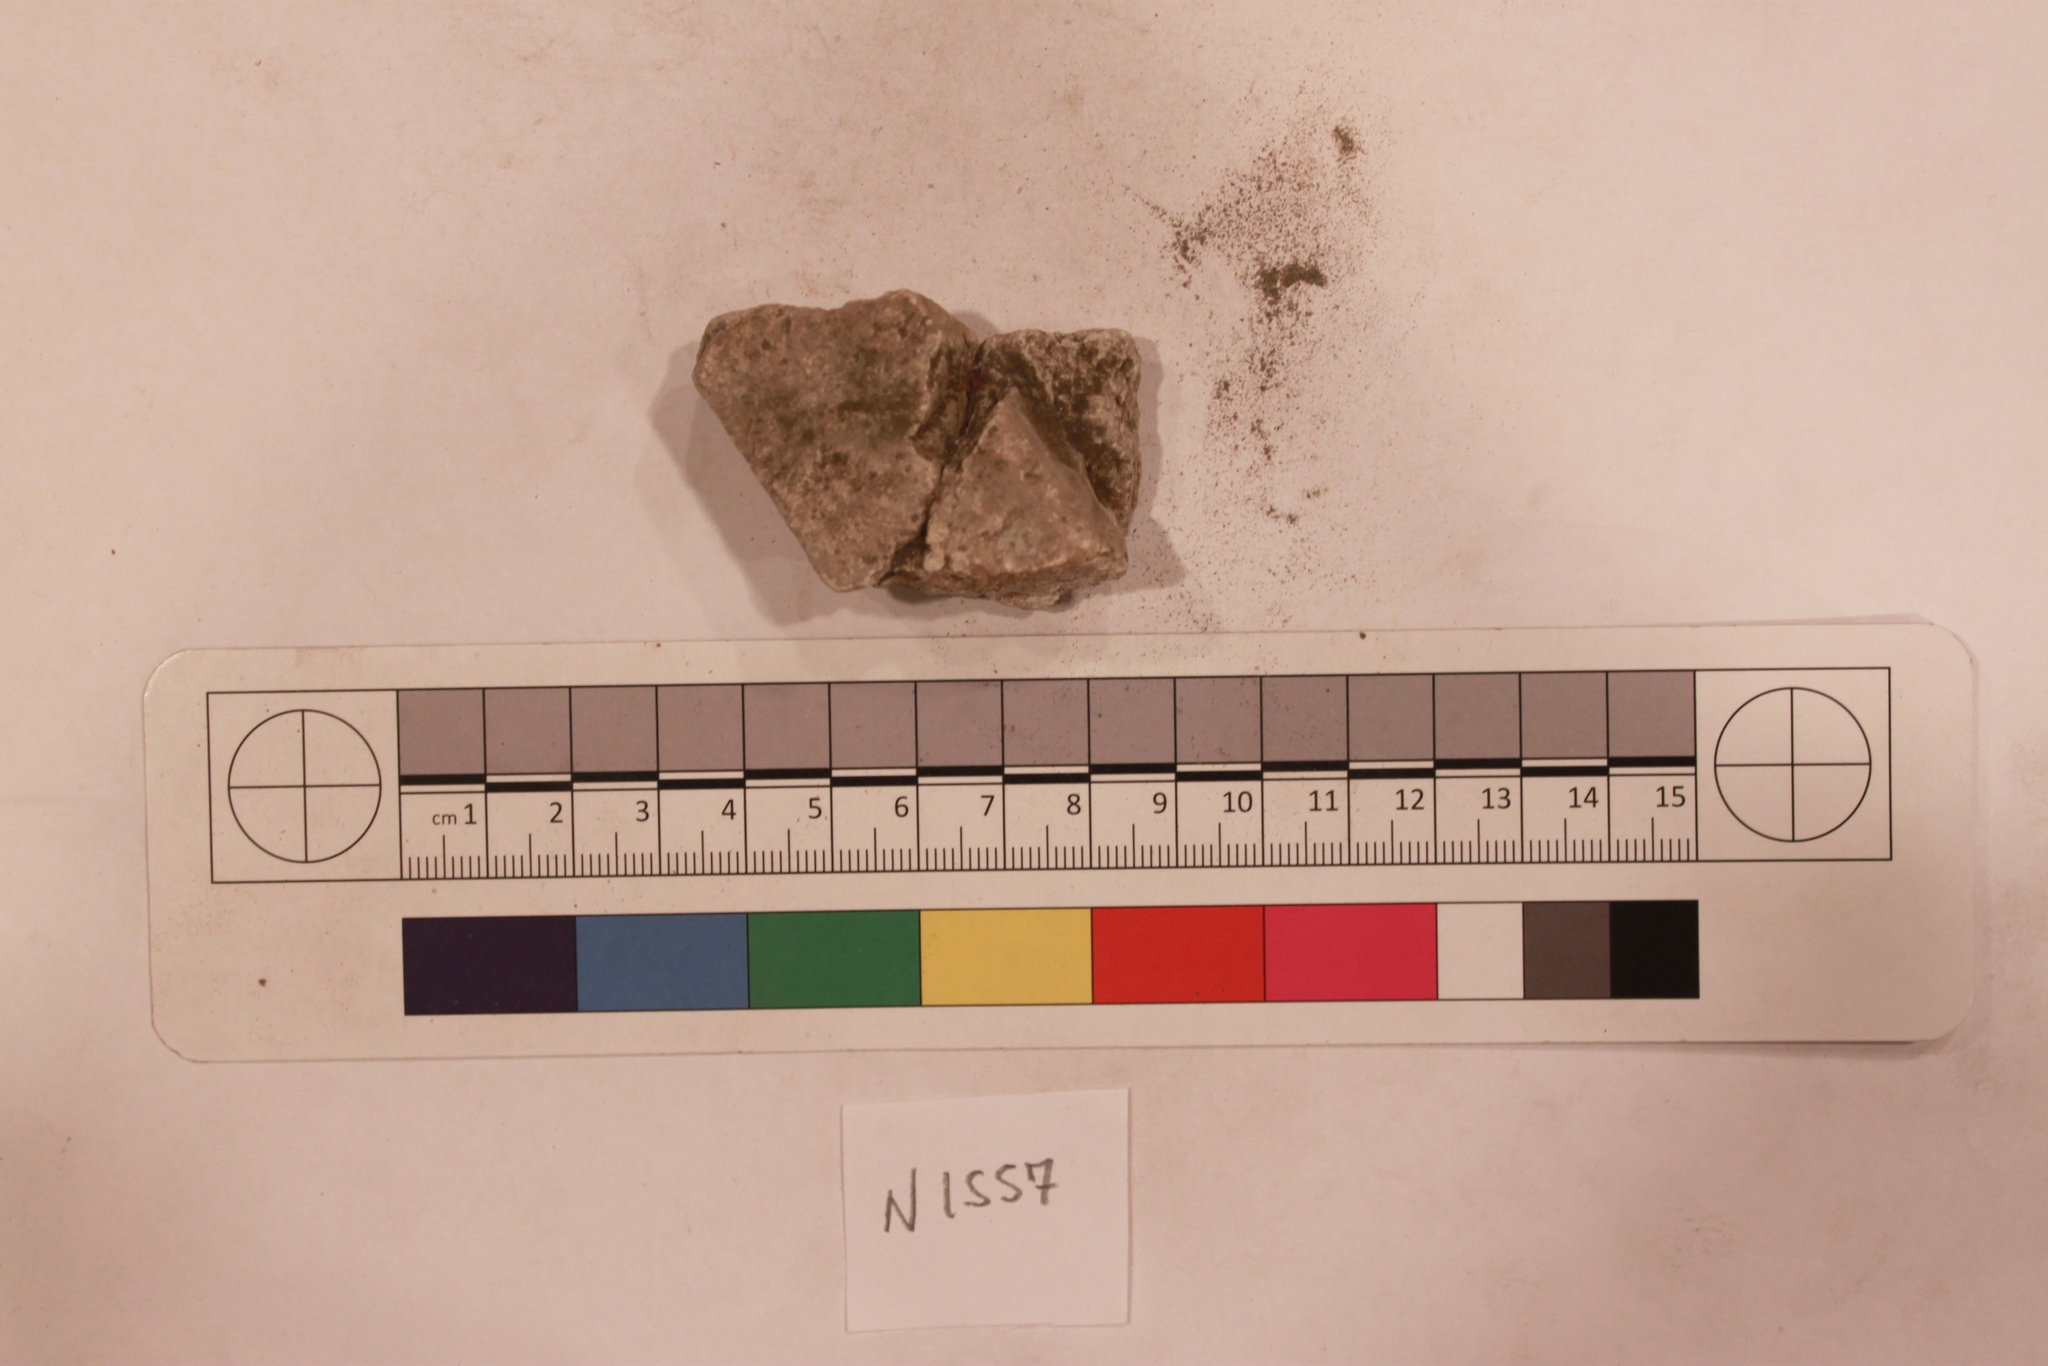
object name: fragment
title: Stucco Fragment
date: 701-1200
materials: plaster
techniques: carving, painting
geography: iran